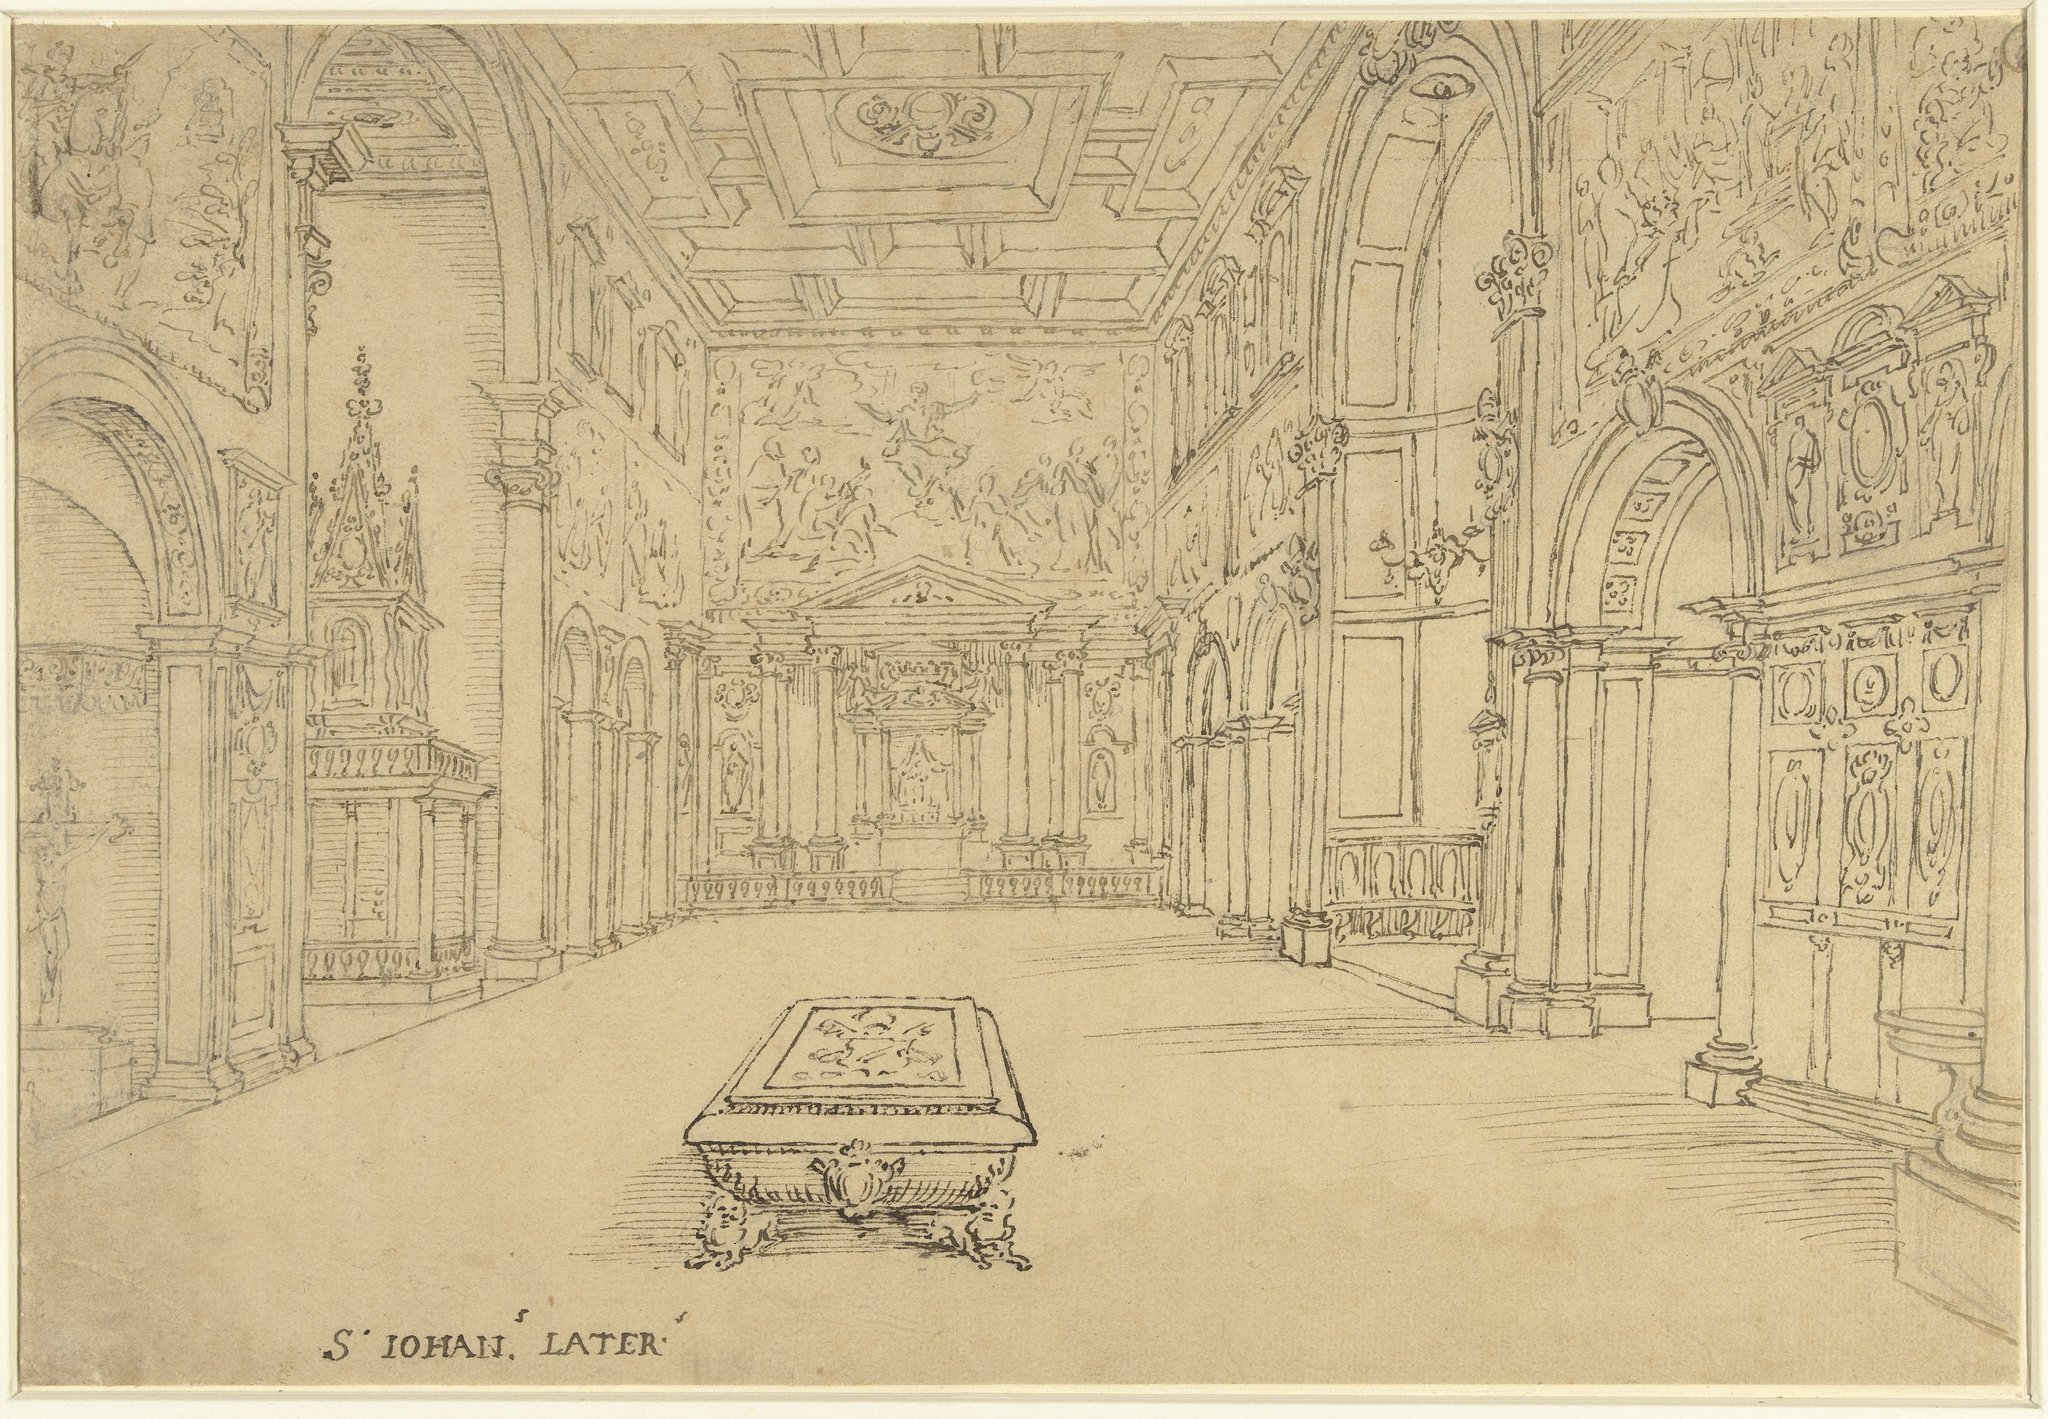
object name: drawing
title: Interieur van de Sint-Jan in Lateranen te Rome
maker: Anonymous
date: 1675-1725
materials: ink, paper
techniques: pen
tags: interior of church, rome